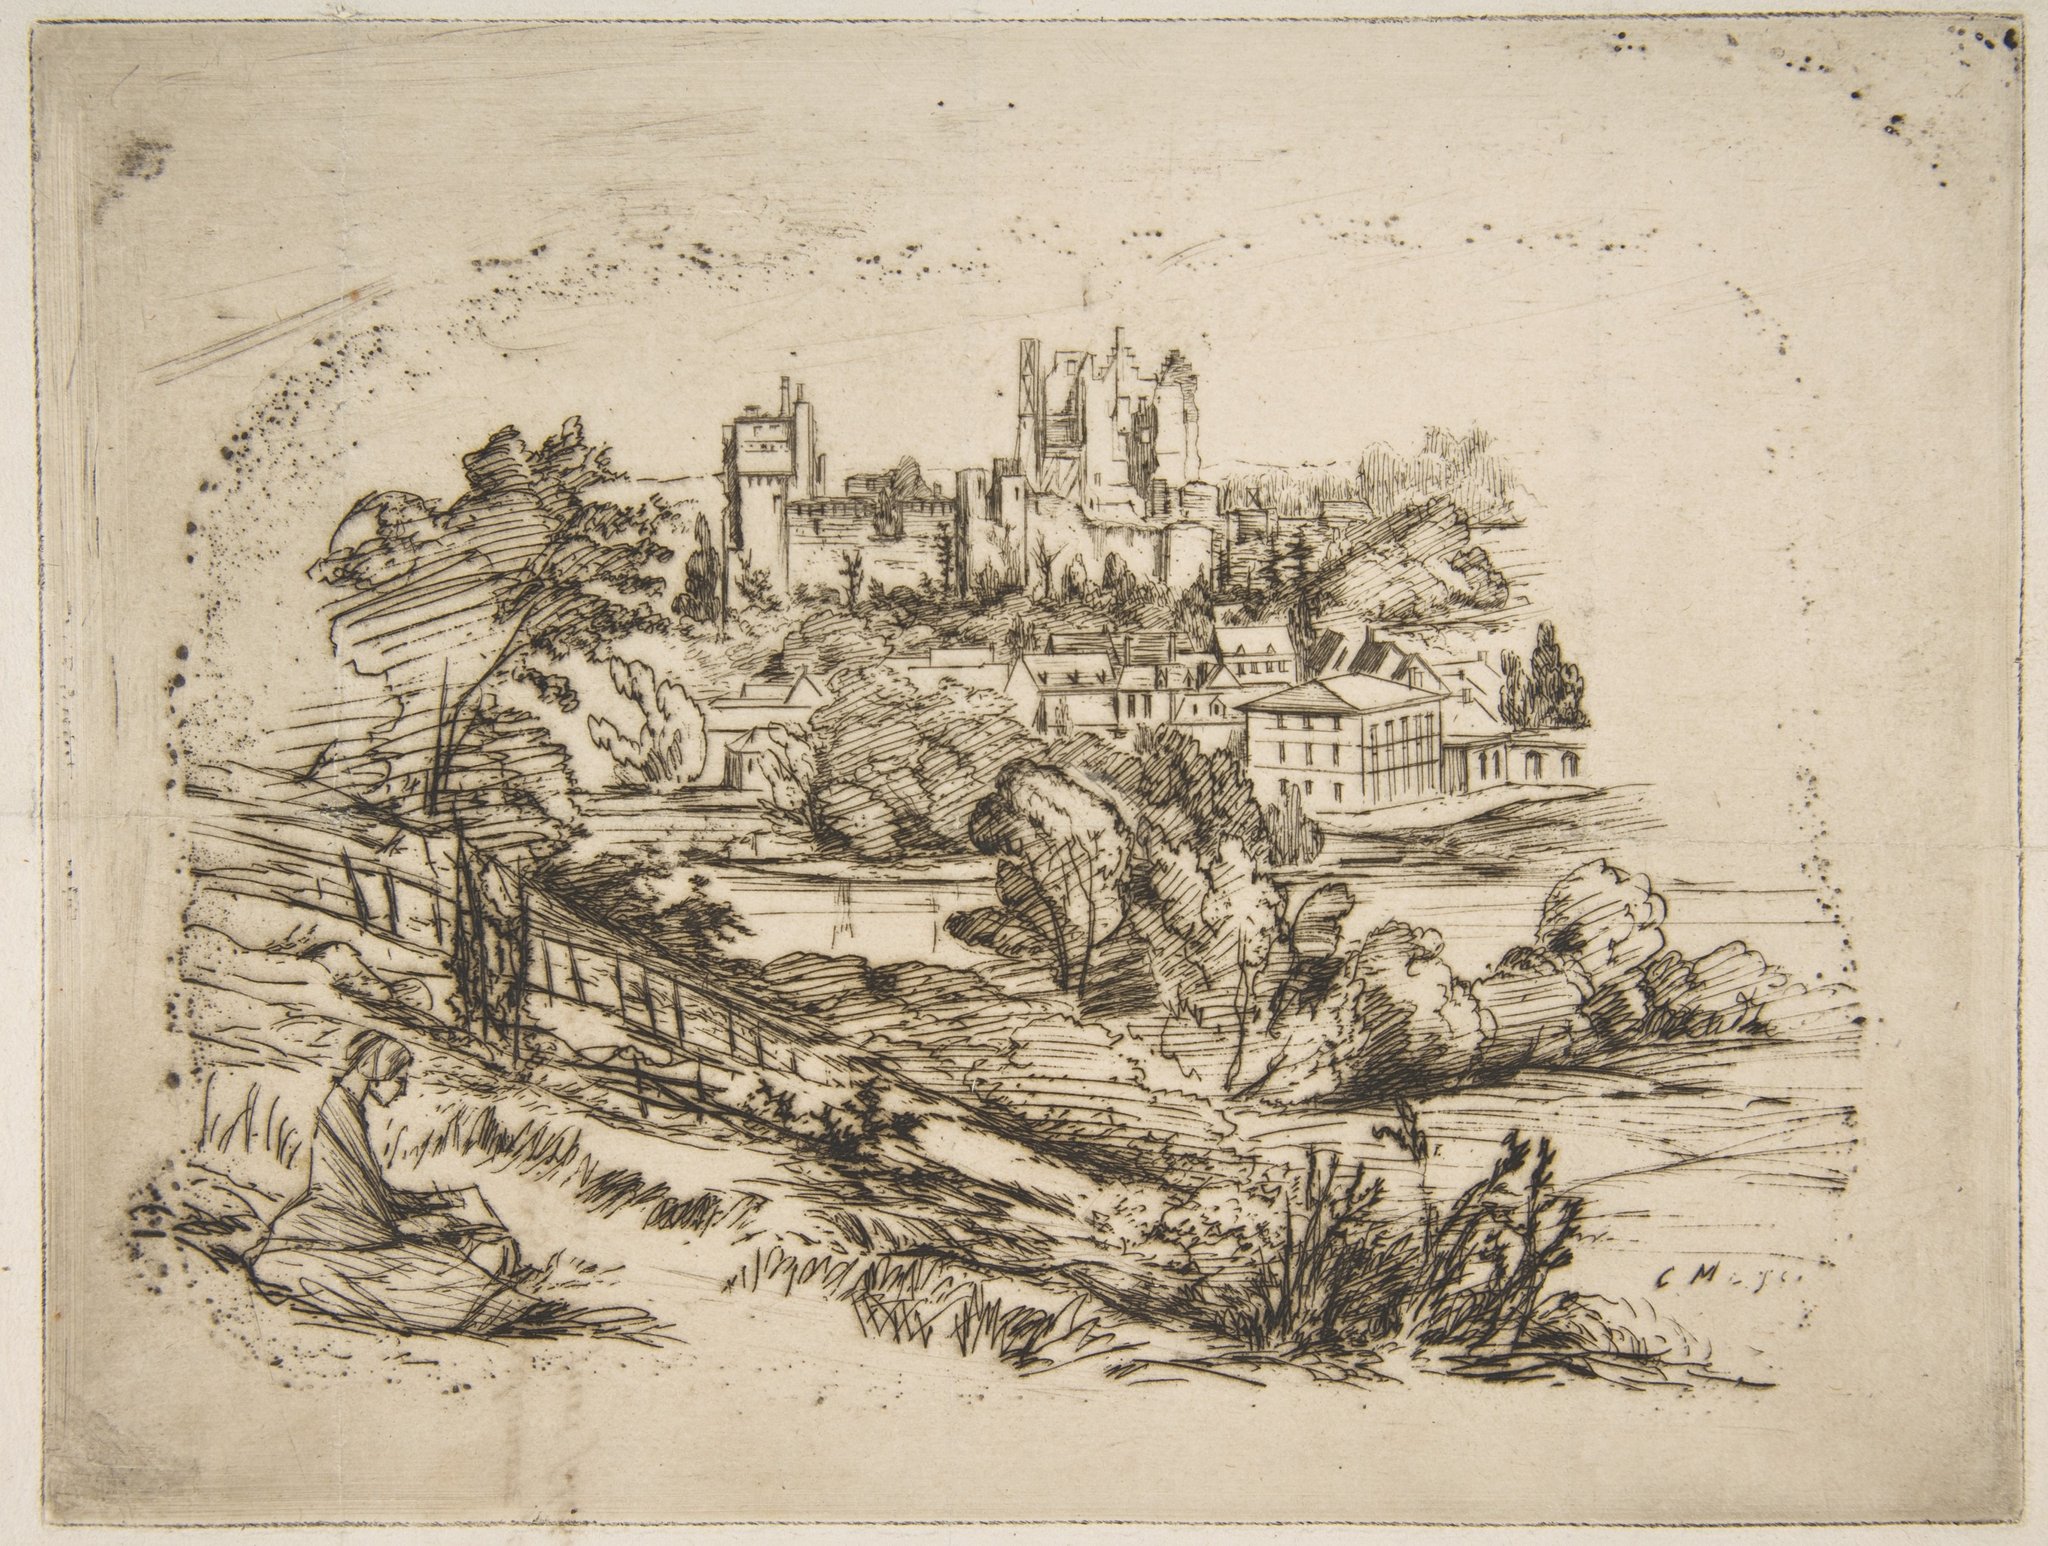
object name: print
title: Ruines du Château de Pierrefonds (Ruins of the Château de Pierrefonds)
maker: charles meryon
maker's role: artist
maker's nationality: french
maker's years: 1821-1868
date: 1858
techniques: drypoint, etching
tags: castles,ruins,women,trees